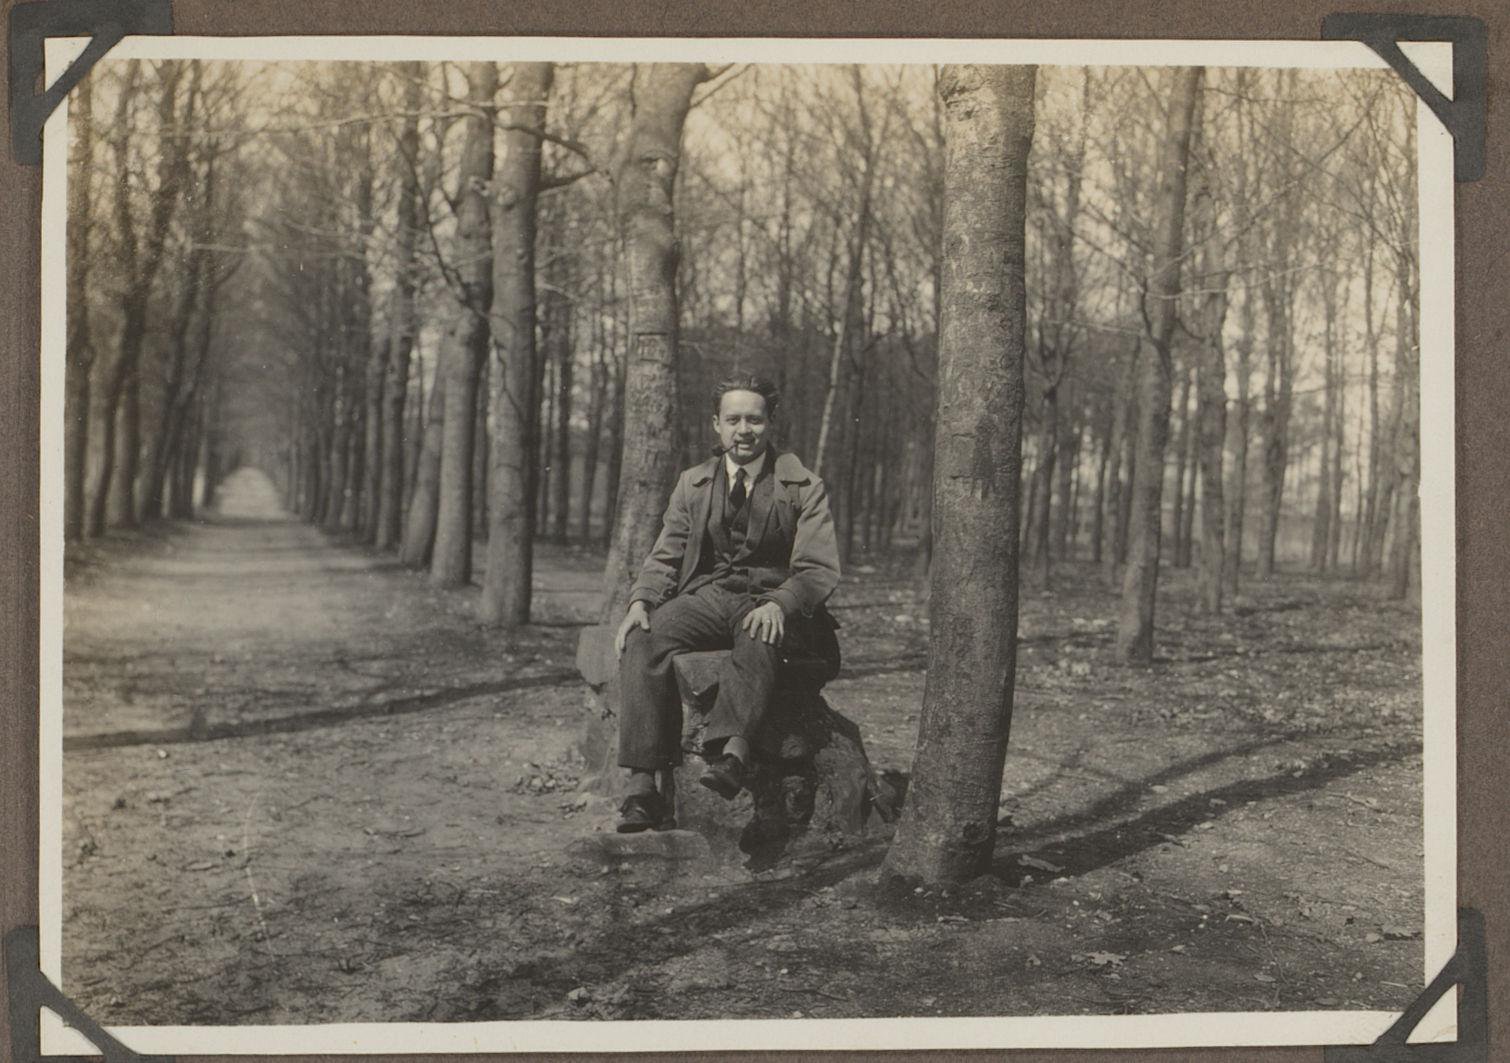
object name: photograph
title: Johannes van Zijll de Jong zittend aan een bosweg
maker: Anonymous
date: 1930-1935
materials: paper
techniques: gelatin silver print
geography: netherlands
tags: adult man, forest path or lane, netherlands